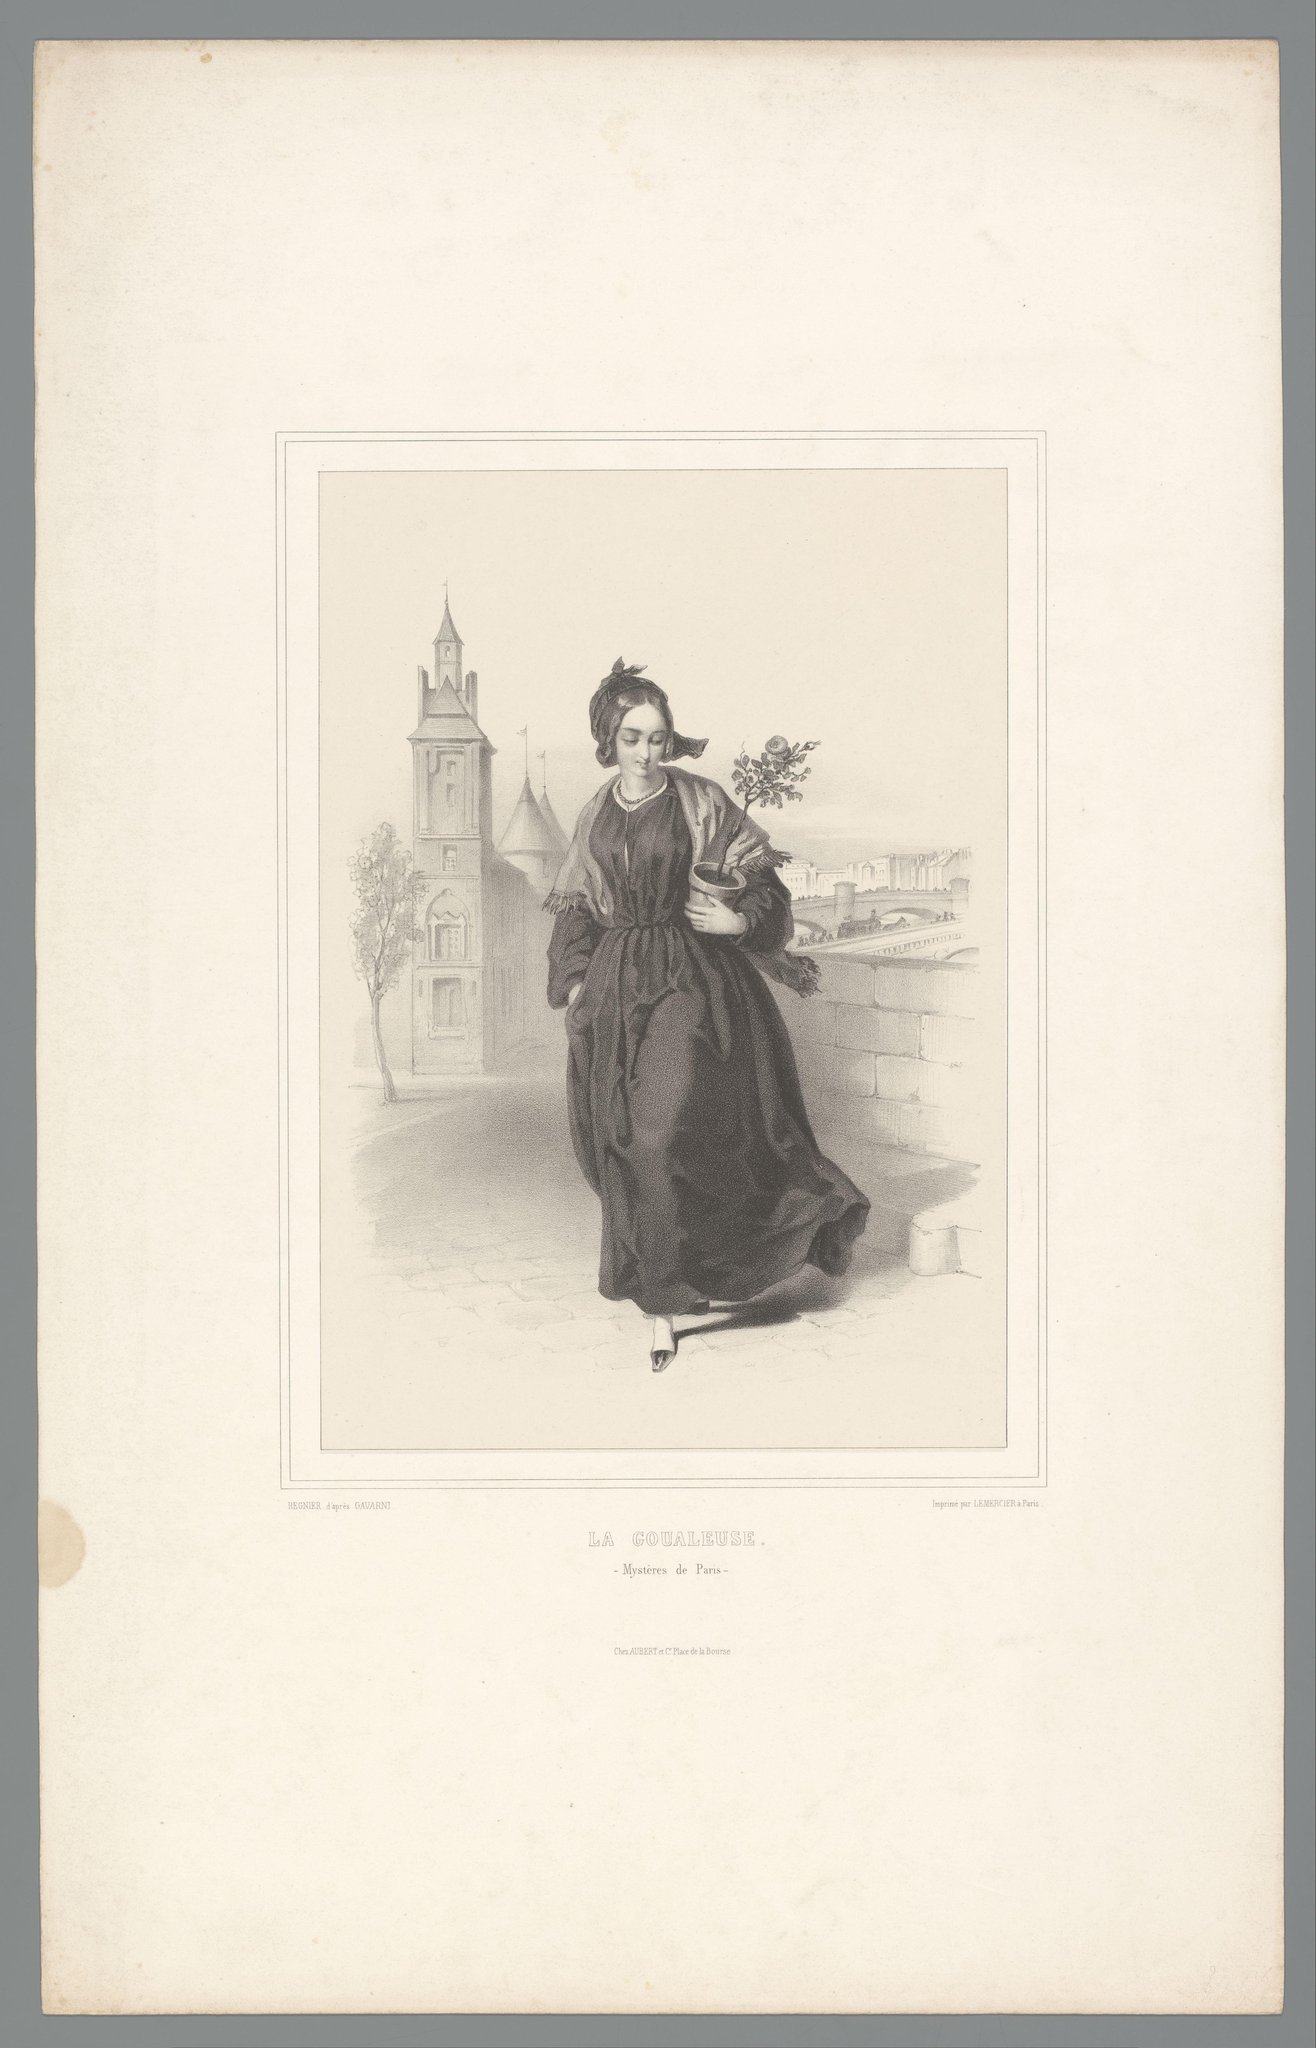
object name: print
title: Personages uit de roman 'Les mystères de Paris' van Eugène Sue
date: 1843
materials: paper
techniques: lithograph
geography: paris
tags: adult woman, plants and herbs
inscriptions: collector's mark: Lugt 2228